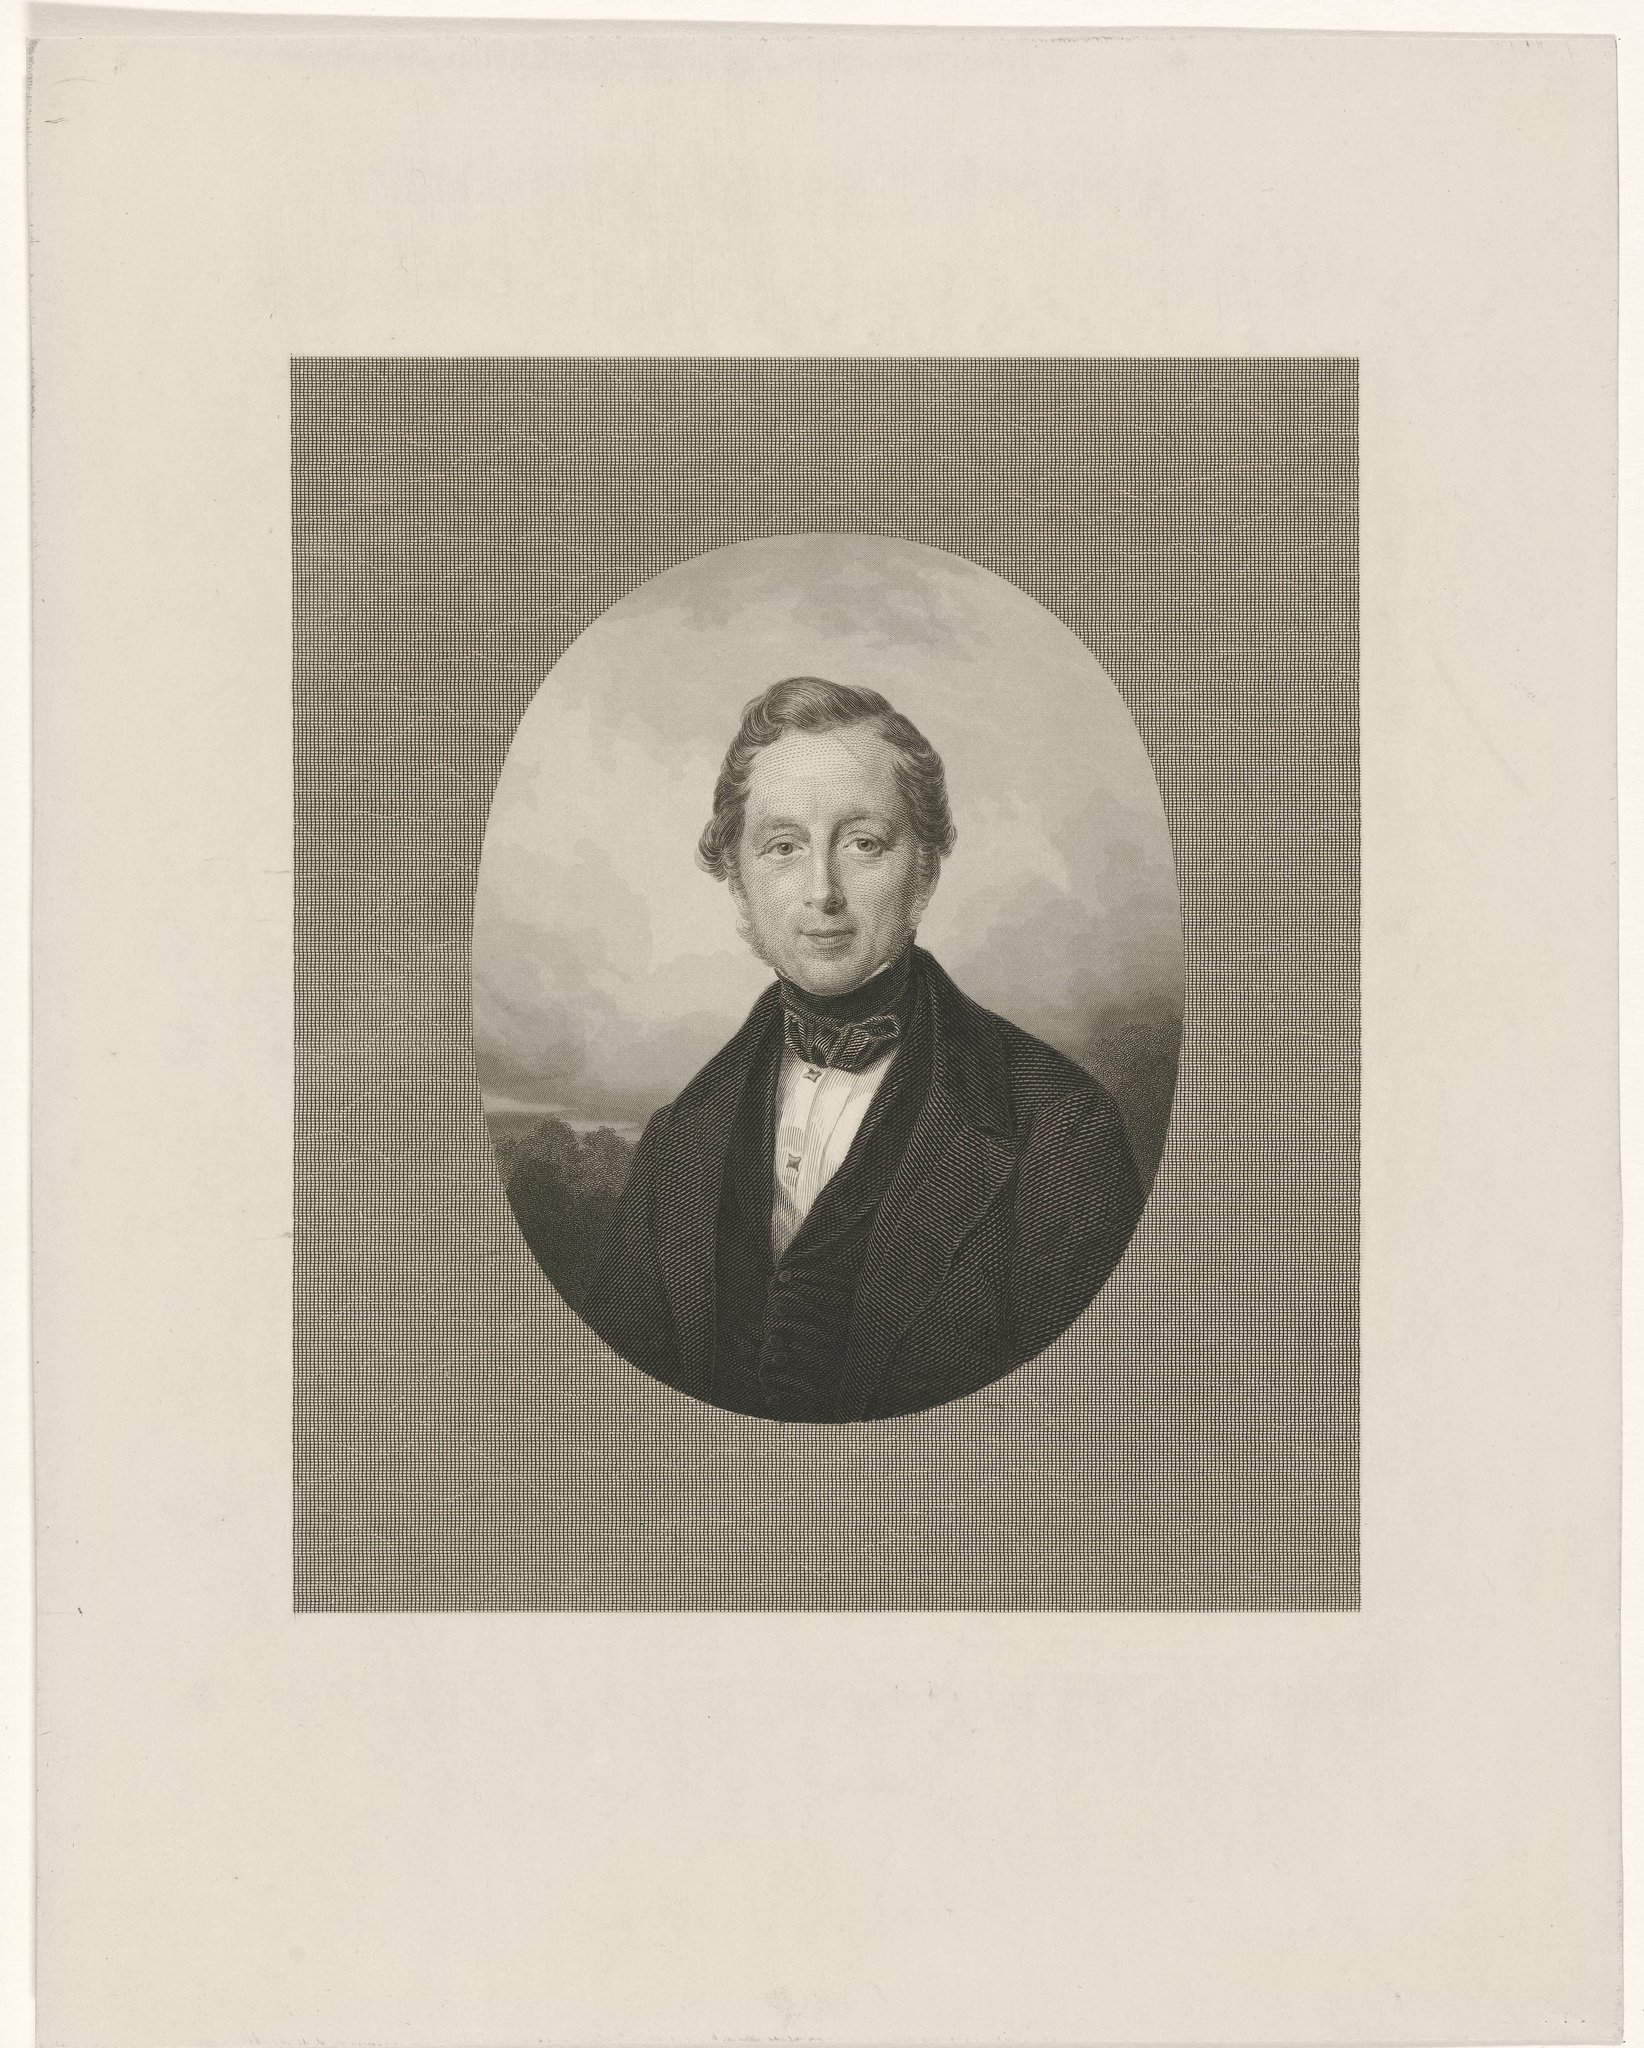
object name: print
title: Portret van Krieger Schumer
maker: johannes philippus lange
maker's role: print maker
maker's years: 1810-1849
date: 1820-1849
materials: paper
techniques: engraving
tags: geneeskundige, krieger schumer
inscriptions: collector's mark: Lugt 2228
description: Portretbuste in ovaal naar links van Krieger Schumer, arts te Amsterdam.